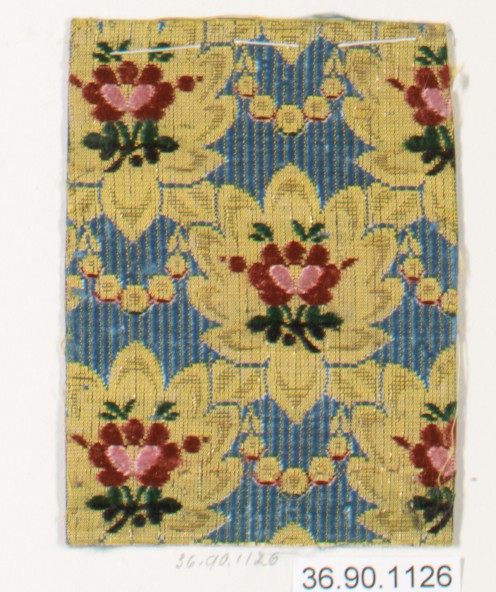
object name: sample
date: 1701-1900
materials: metal thread, silk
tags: flowers